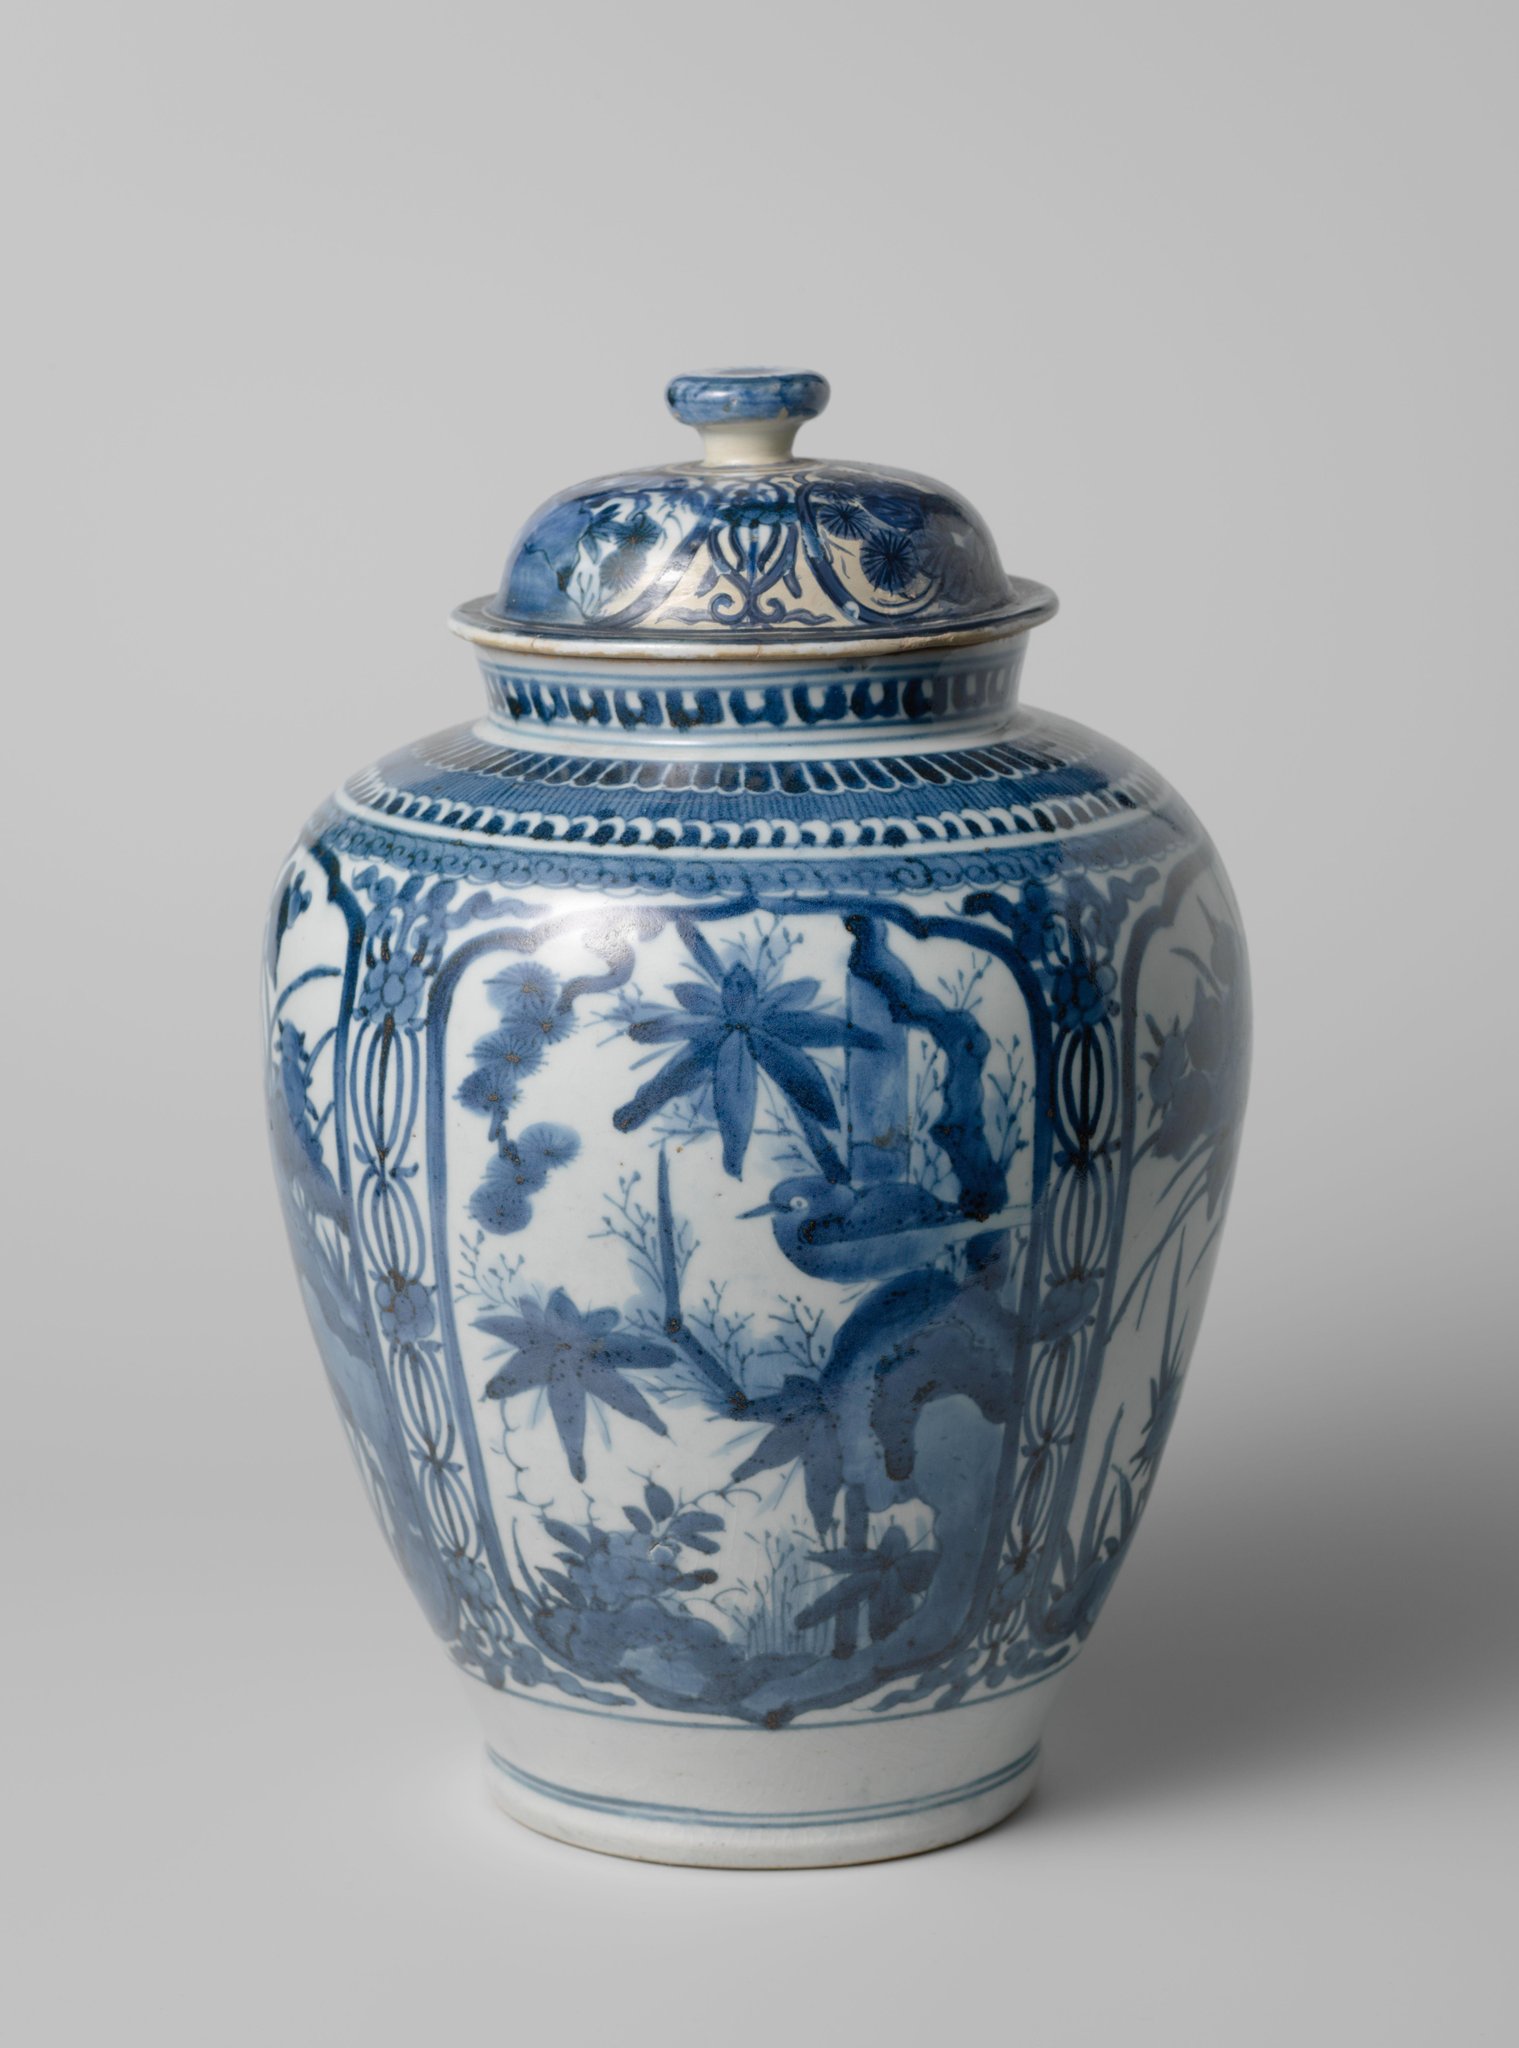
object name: covered jar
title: Ovoid covered jar with a bird on a rock and flowering plants in panels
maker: Anonymous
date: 1650-1680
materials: cobalt, glaze, paint, porcelain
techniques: firing, turning, vitrification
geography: japan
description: Eivormige dekselpot van porselein, beschilderd in onderglazuur blauw. Op de buik vier geschulpte cartouches met in twee een vogel op een rots bij planten (pijnboom, bamboe), in de andere twee een bloeiende plant (pioen) bij een rots. Tussen de cartouches gestileerde bloemranken. Op de schouder en de hals een decoratieve band. De vaas is gebroken geweest. Blauw-wit.